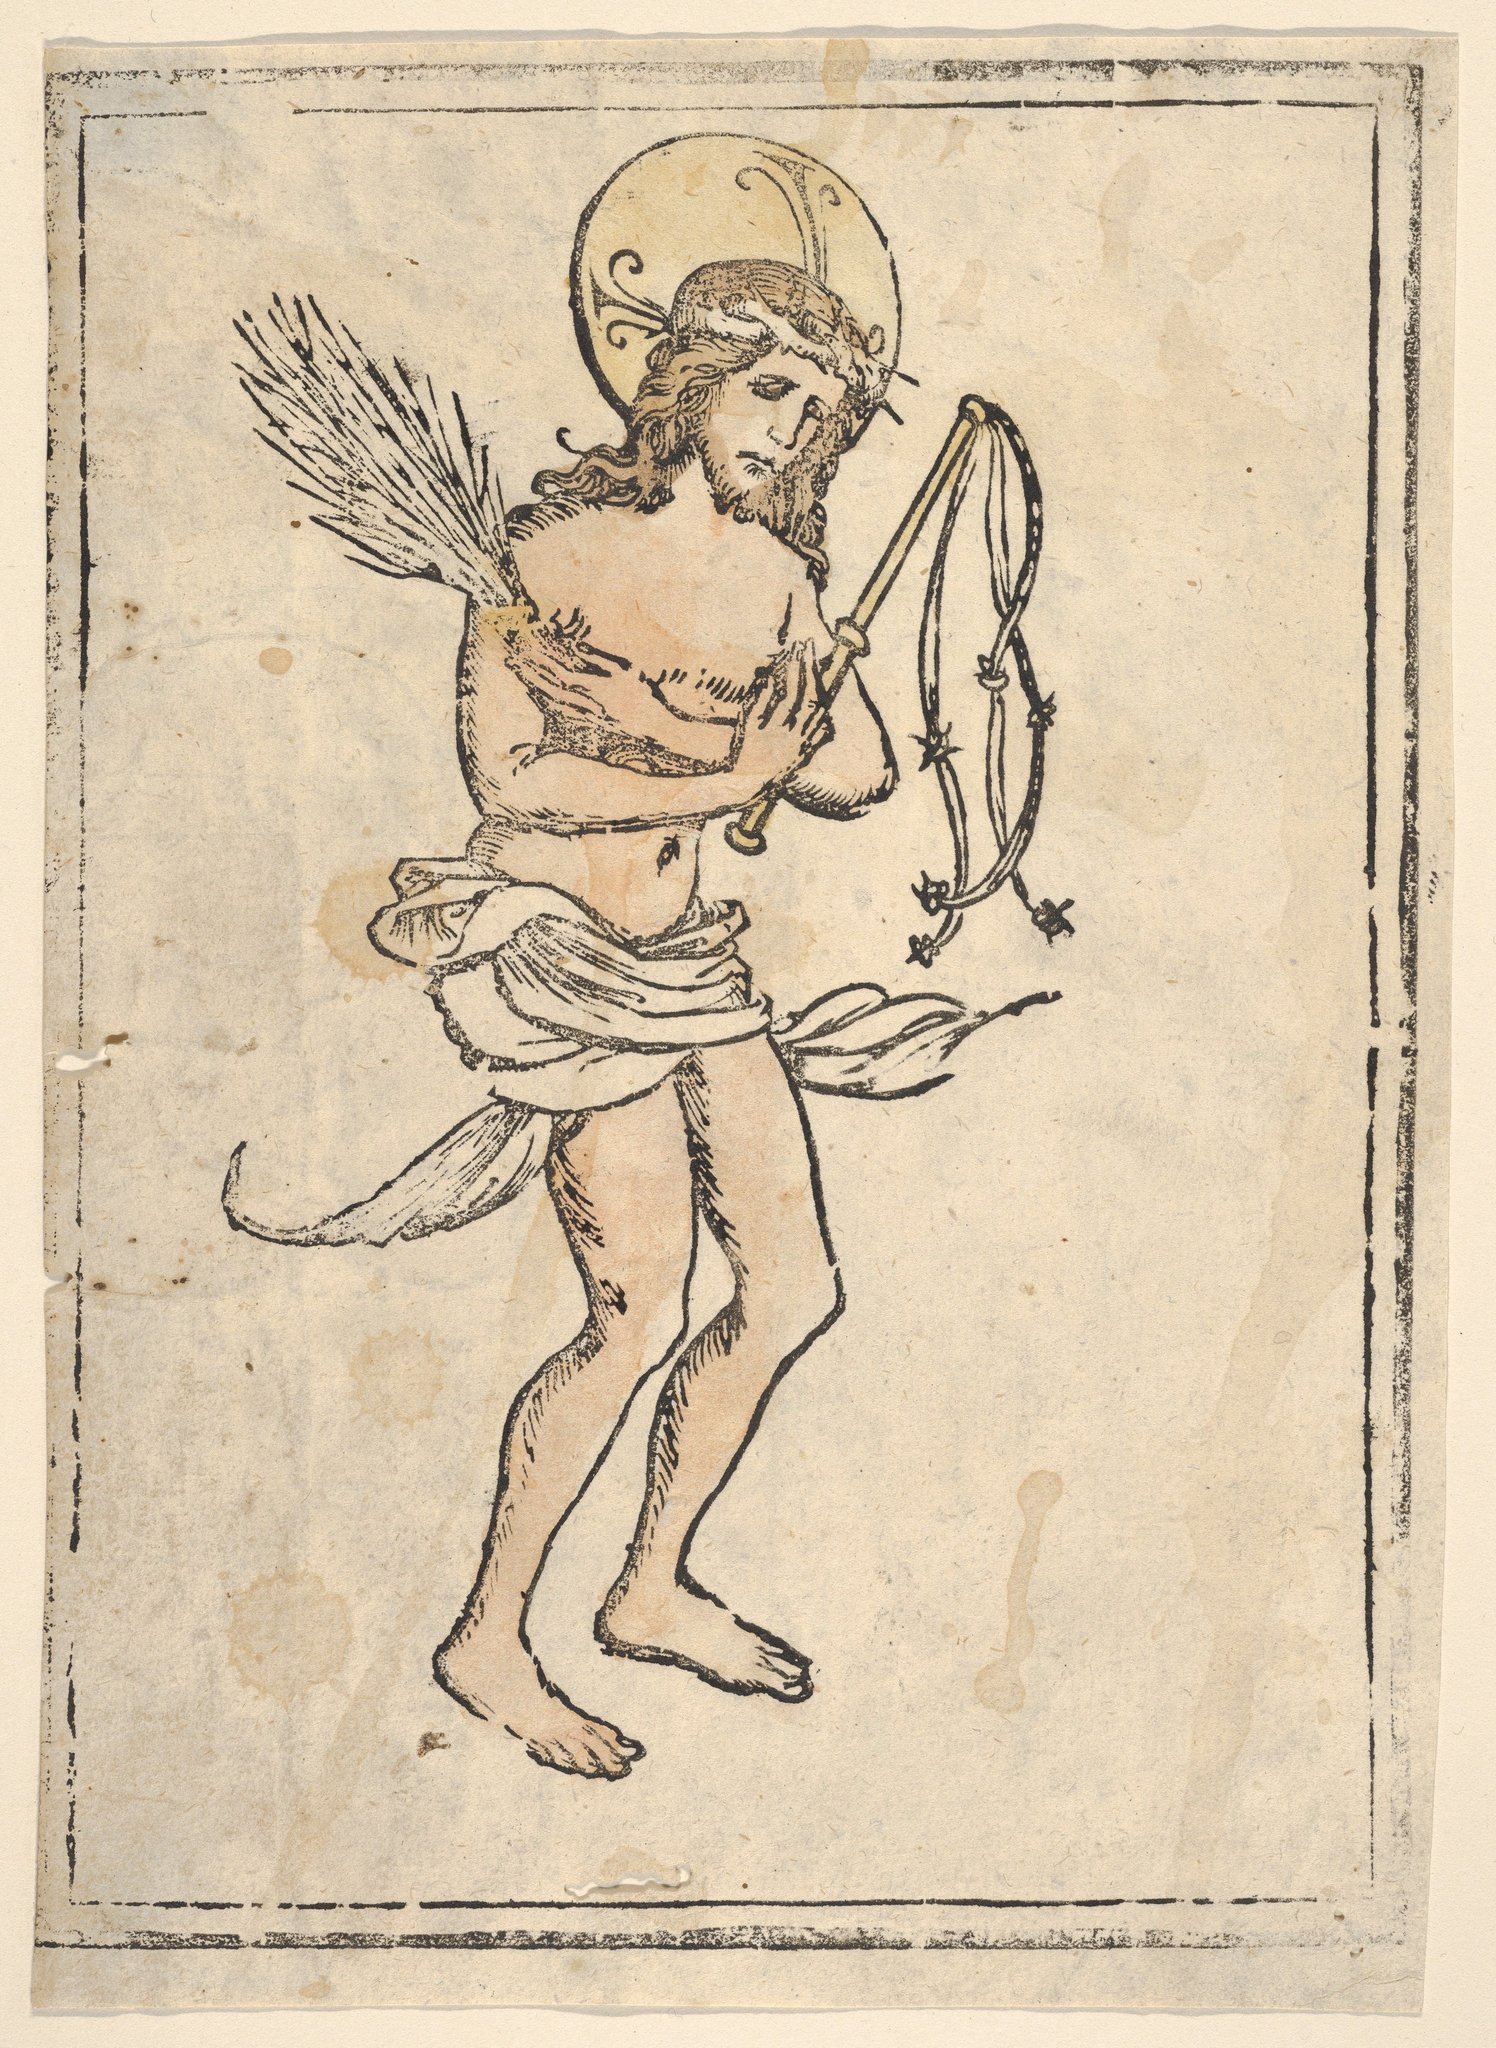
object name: print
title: The Man of Sorrows Standing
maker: hans burgkmair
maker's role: artist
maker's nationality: german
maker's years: 1473-1531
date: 1498-1531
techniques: hand coloring, woodcut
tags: christ